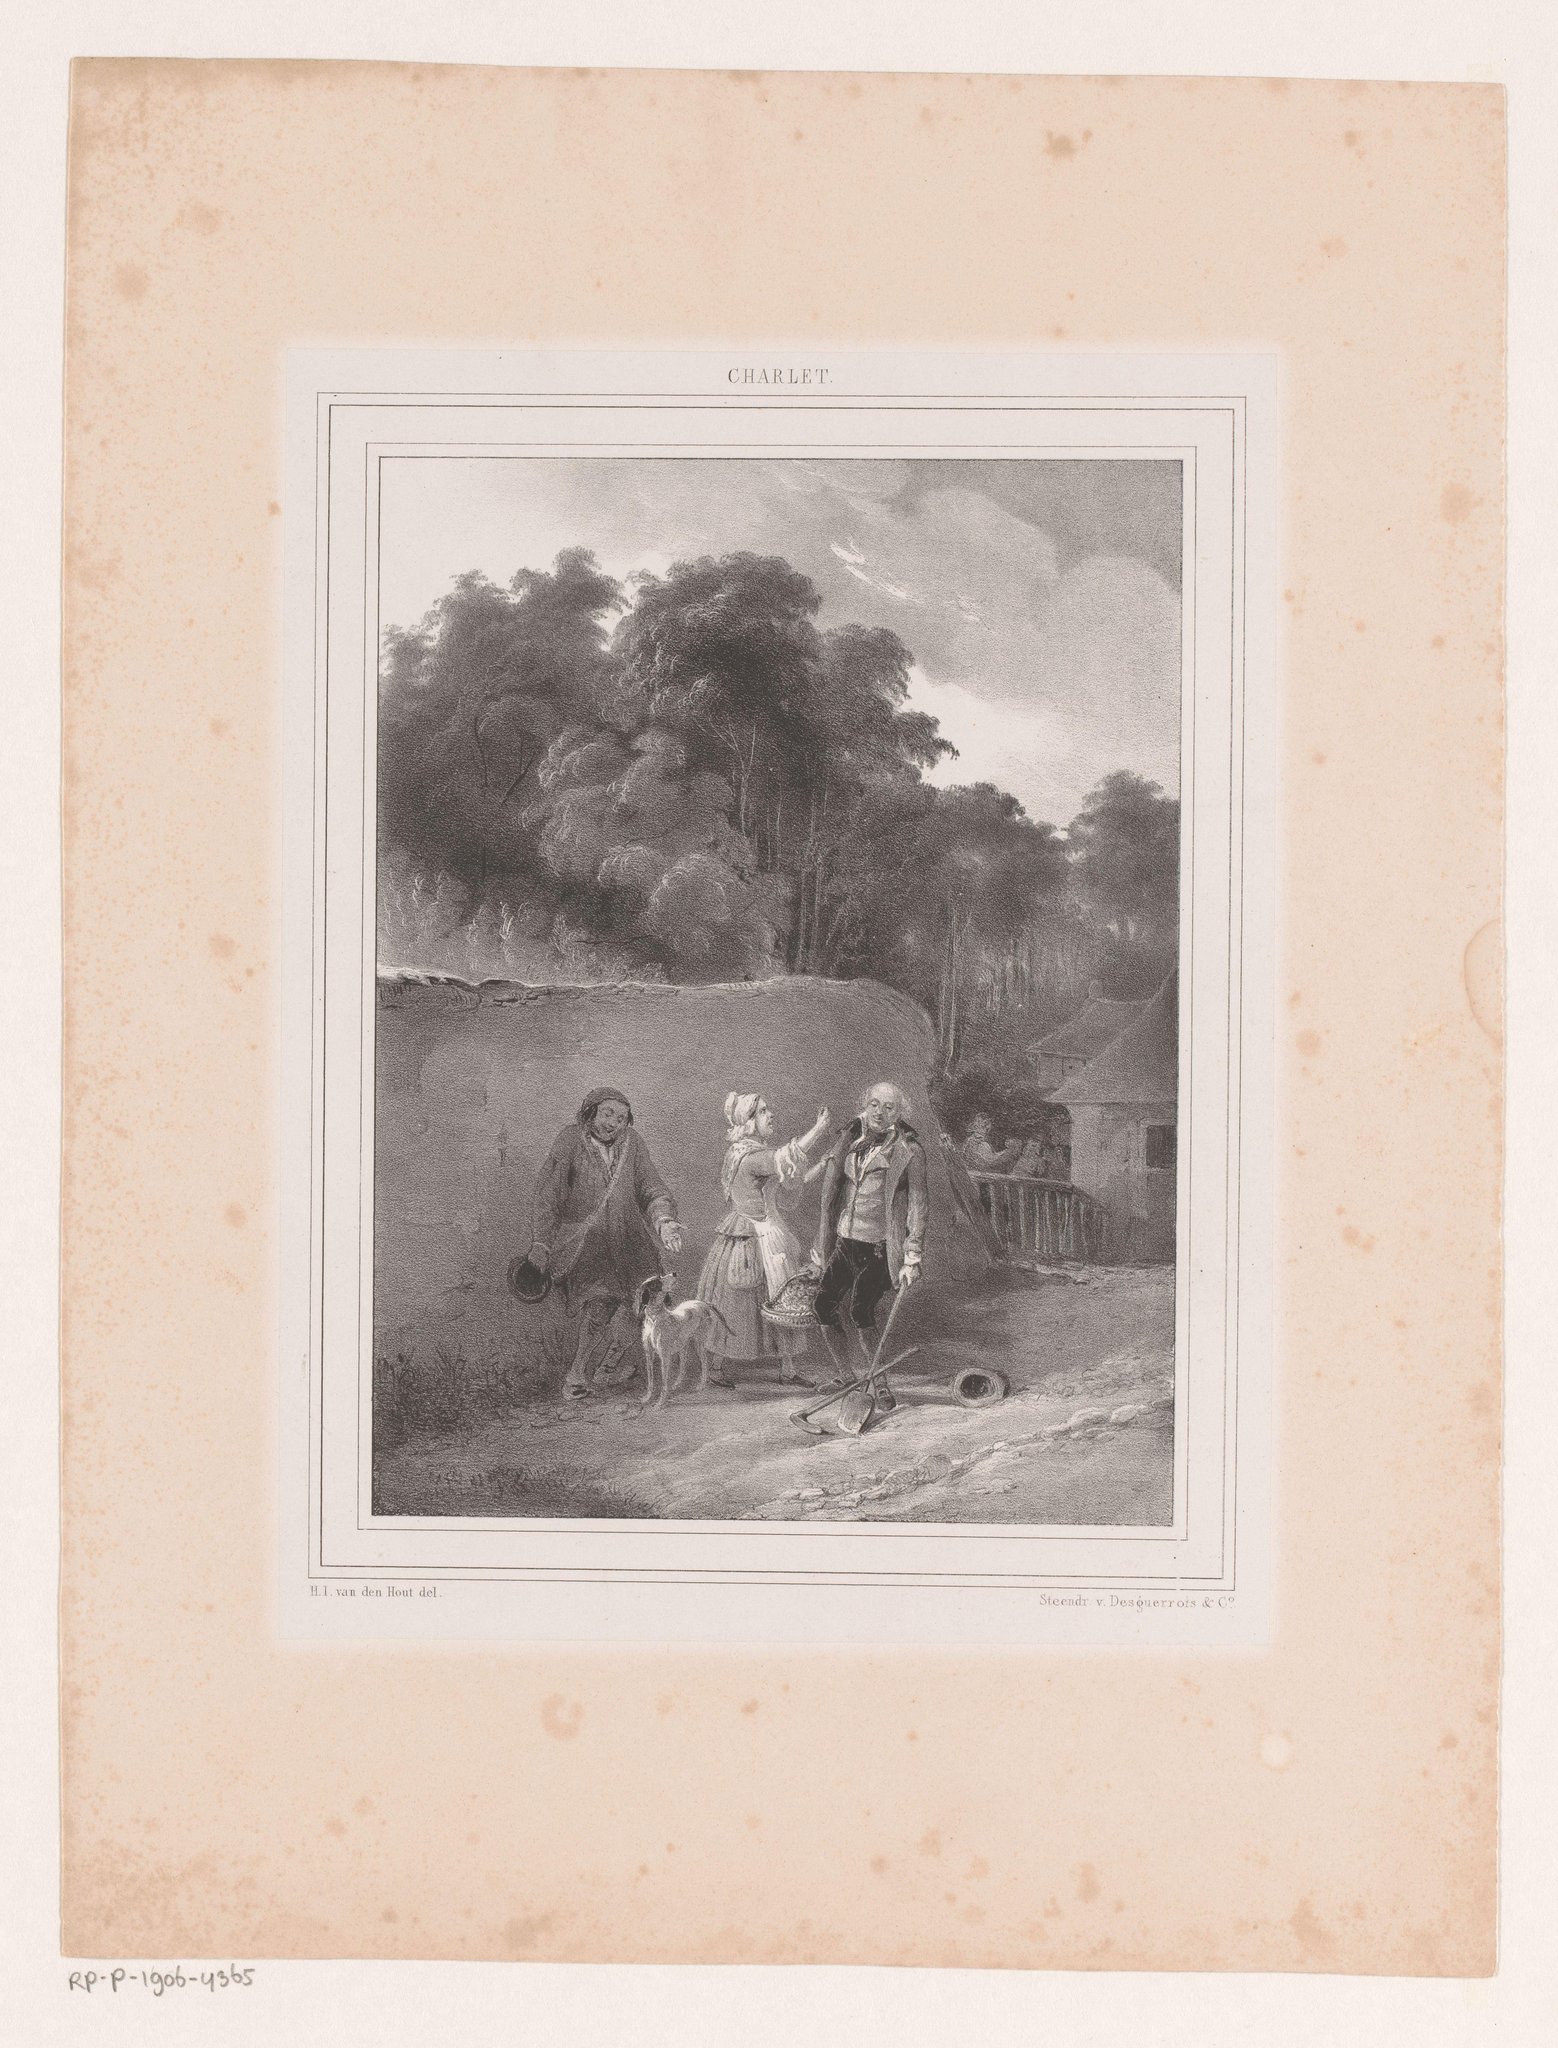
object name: print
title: Ontmoeting op straat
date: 1823-1869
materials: paper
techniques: lithograph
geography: amsterdam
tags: slap in the face, meeting, street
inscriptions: collector's mark: Lugt 2228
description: De vrouw heeft de man bij zijn jas gegrepen en heft haar rechterhand dicht bij zijn gezicht. De man heeft zijn gereedschap op de grond laten vallen. Naast hen staan een man en een hond.